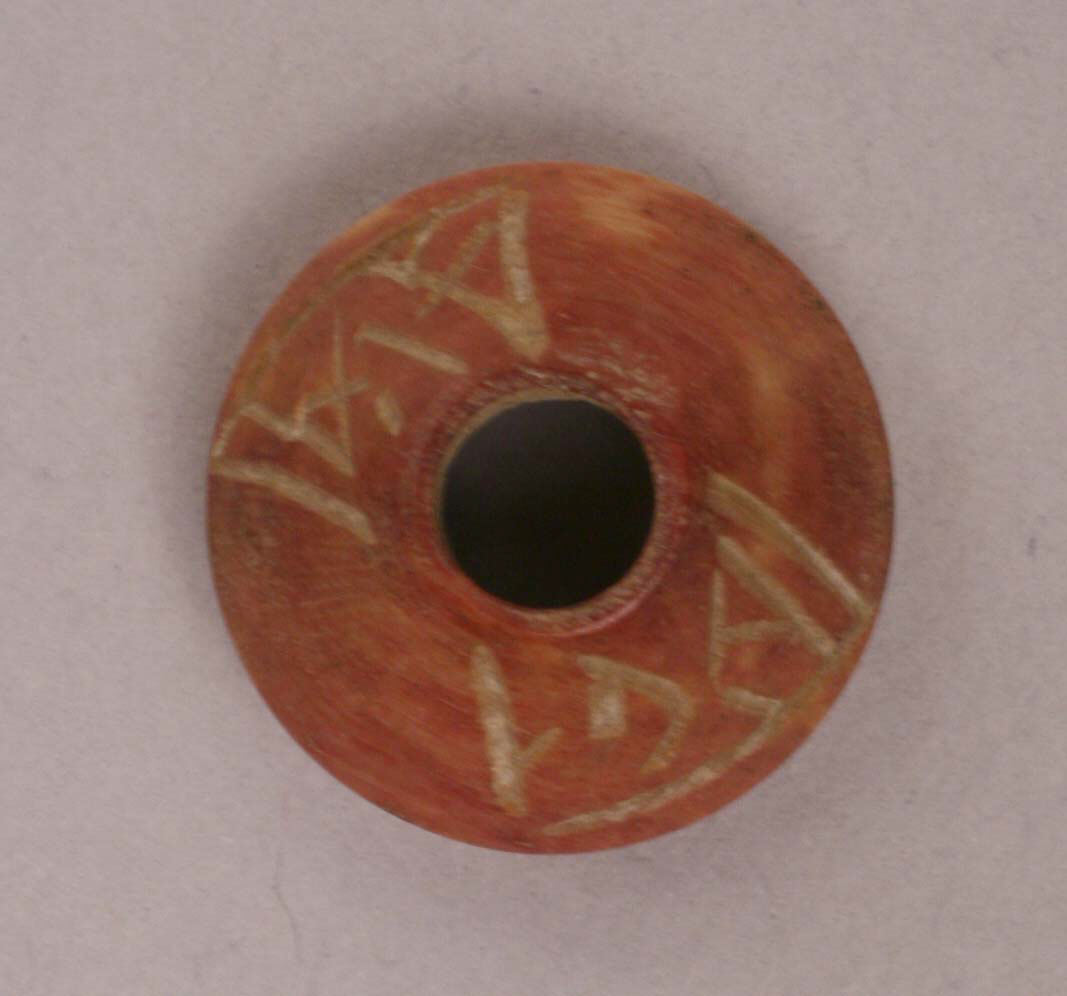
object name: button or bead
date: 801-1000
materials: bone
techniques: incising, tinting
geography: iran